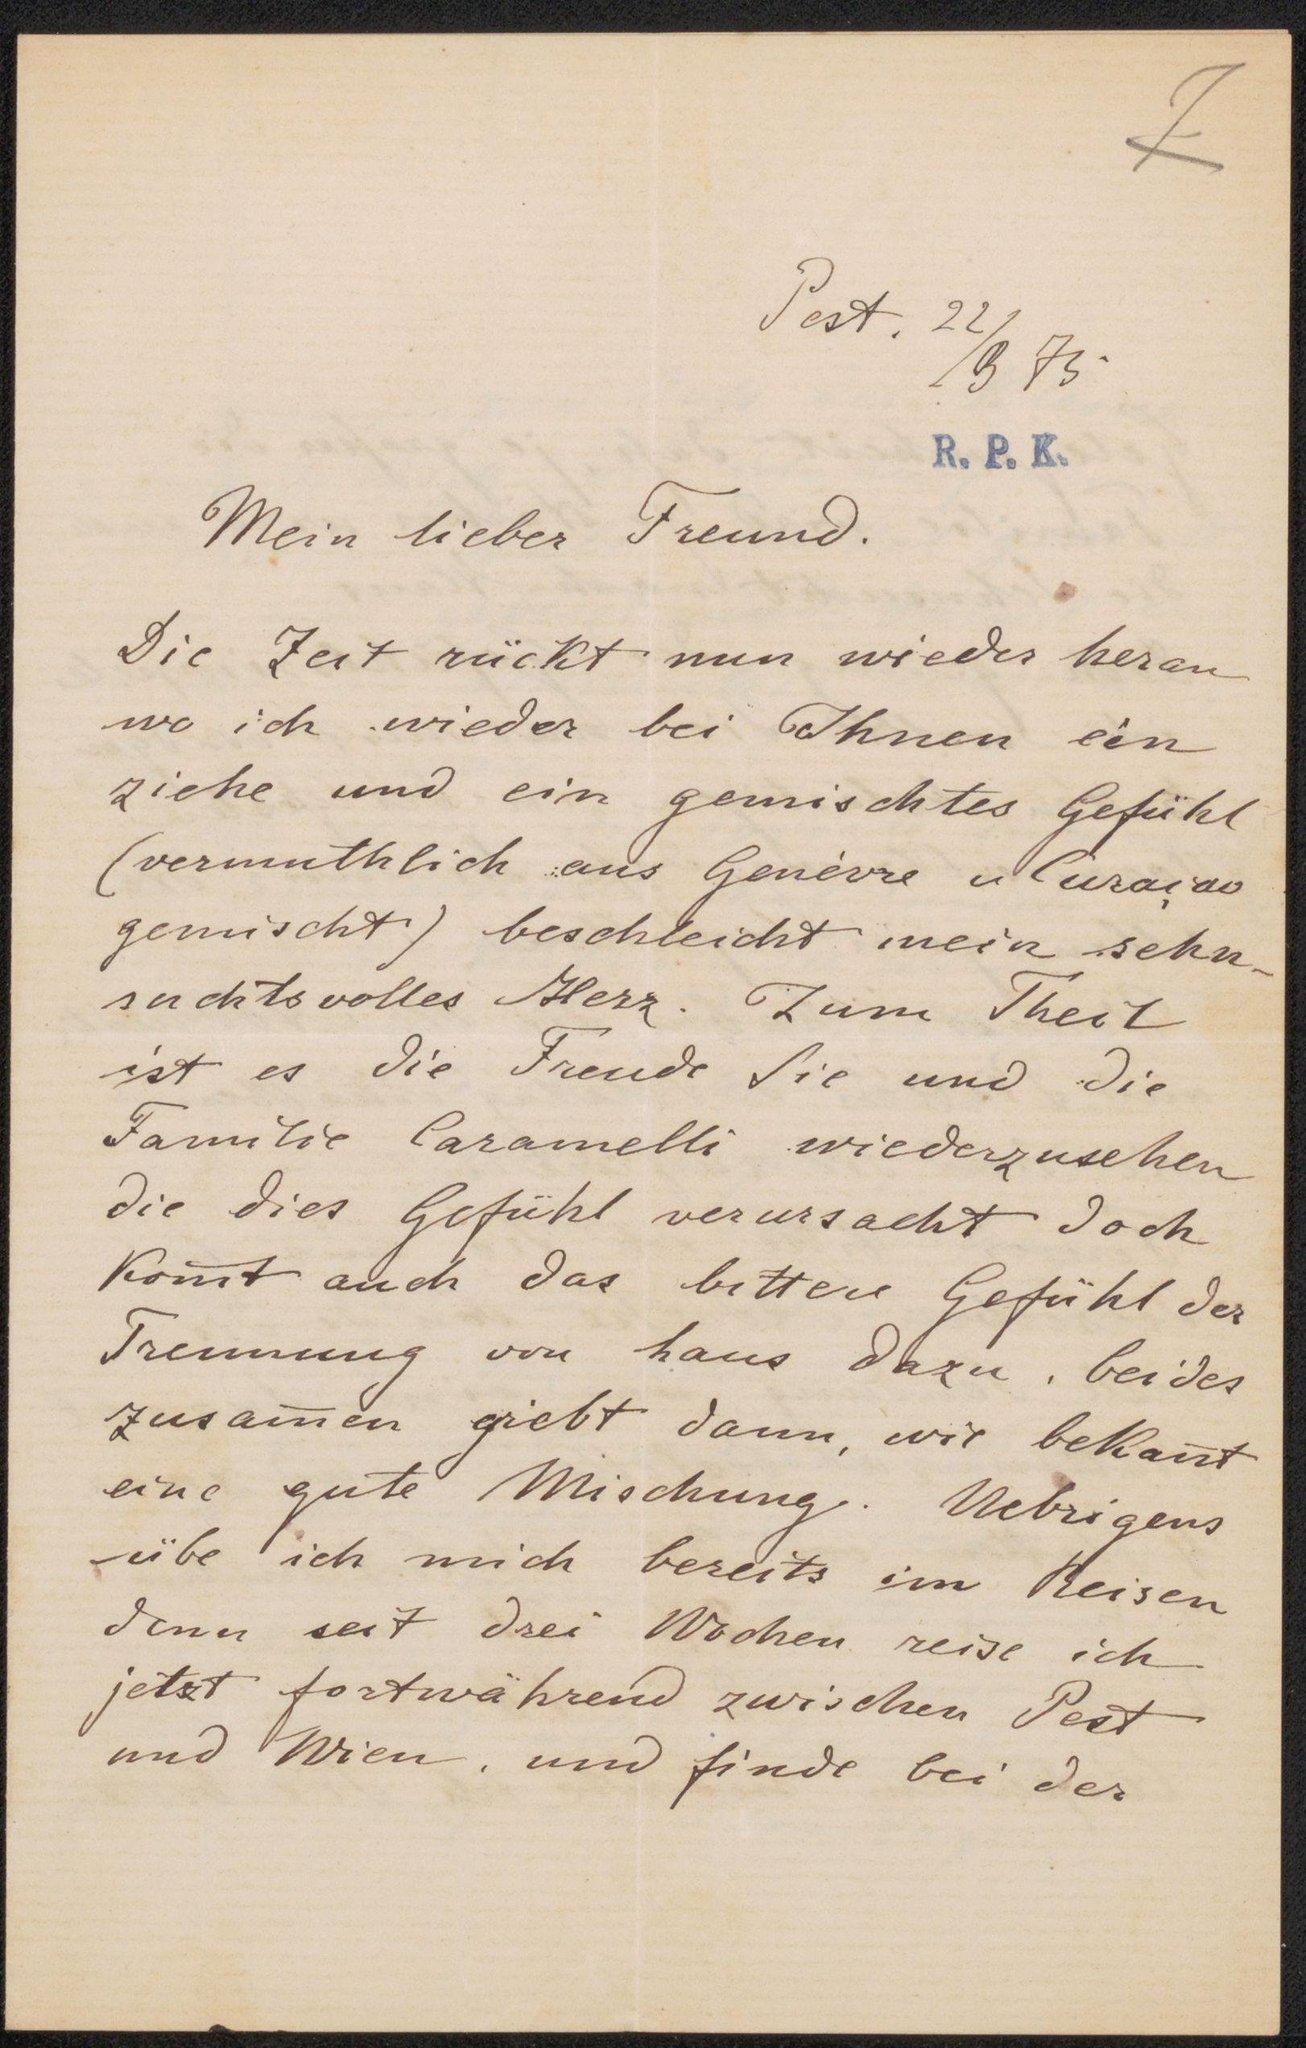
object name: letter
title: Brief aan Filippo Tessaro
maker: william unger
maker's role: draughtsman, painter, print maker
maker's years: 1837-1932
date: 1875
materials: ink, paper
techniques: pen, writing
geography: pest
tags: utrecht, publisher, alberto caramelli, georg friedrich felsing, amsterdam, print maker, draughtsman, jan caramelli, passions, emotions, affections, the graphic arts, travelling; tourism, printed matter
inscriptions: collector's mark: Lugt 2233